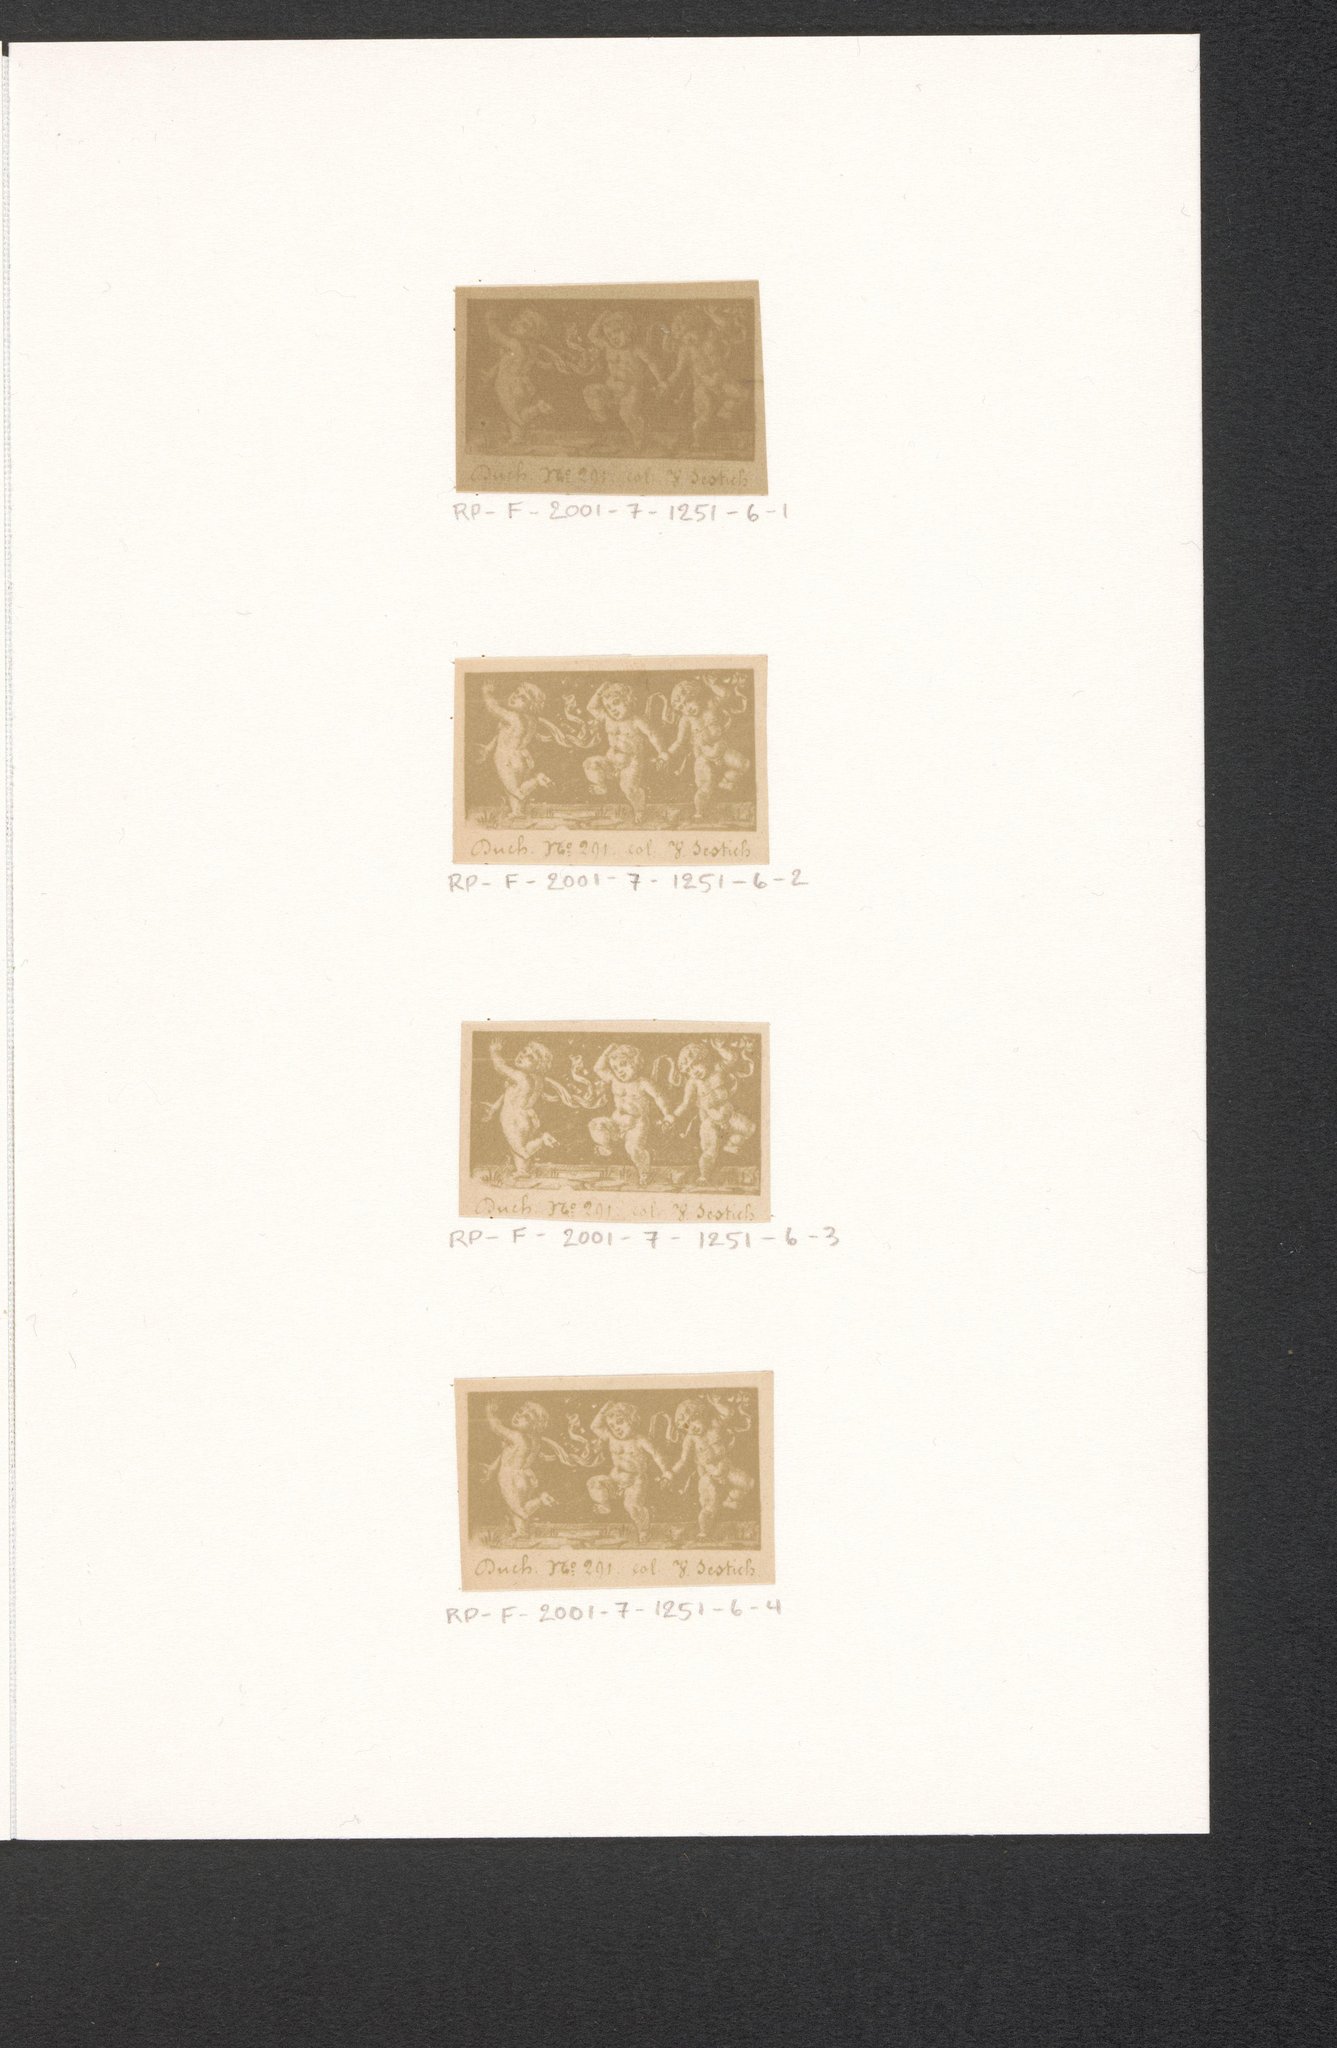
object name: page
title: Fotoreproductie van een prent van drie dansende putti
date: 1852-1857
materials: photographic support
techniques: salted paper print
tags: group dancing, cupids: 'amores', 'amoretti', 'putti'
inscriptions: inscription: ‘Duch. No 2[91. c]ol. V. Sestich’